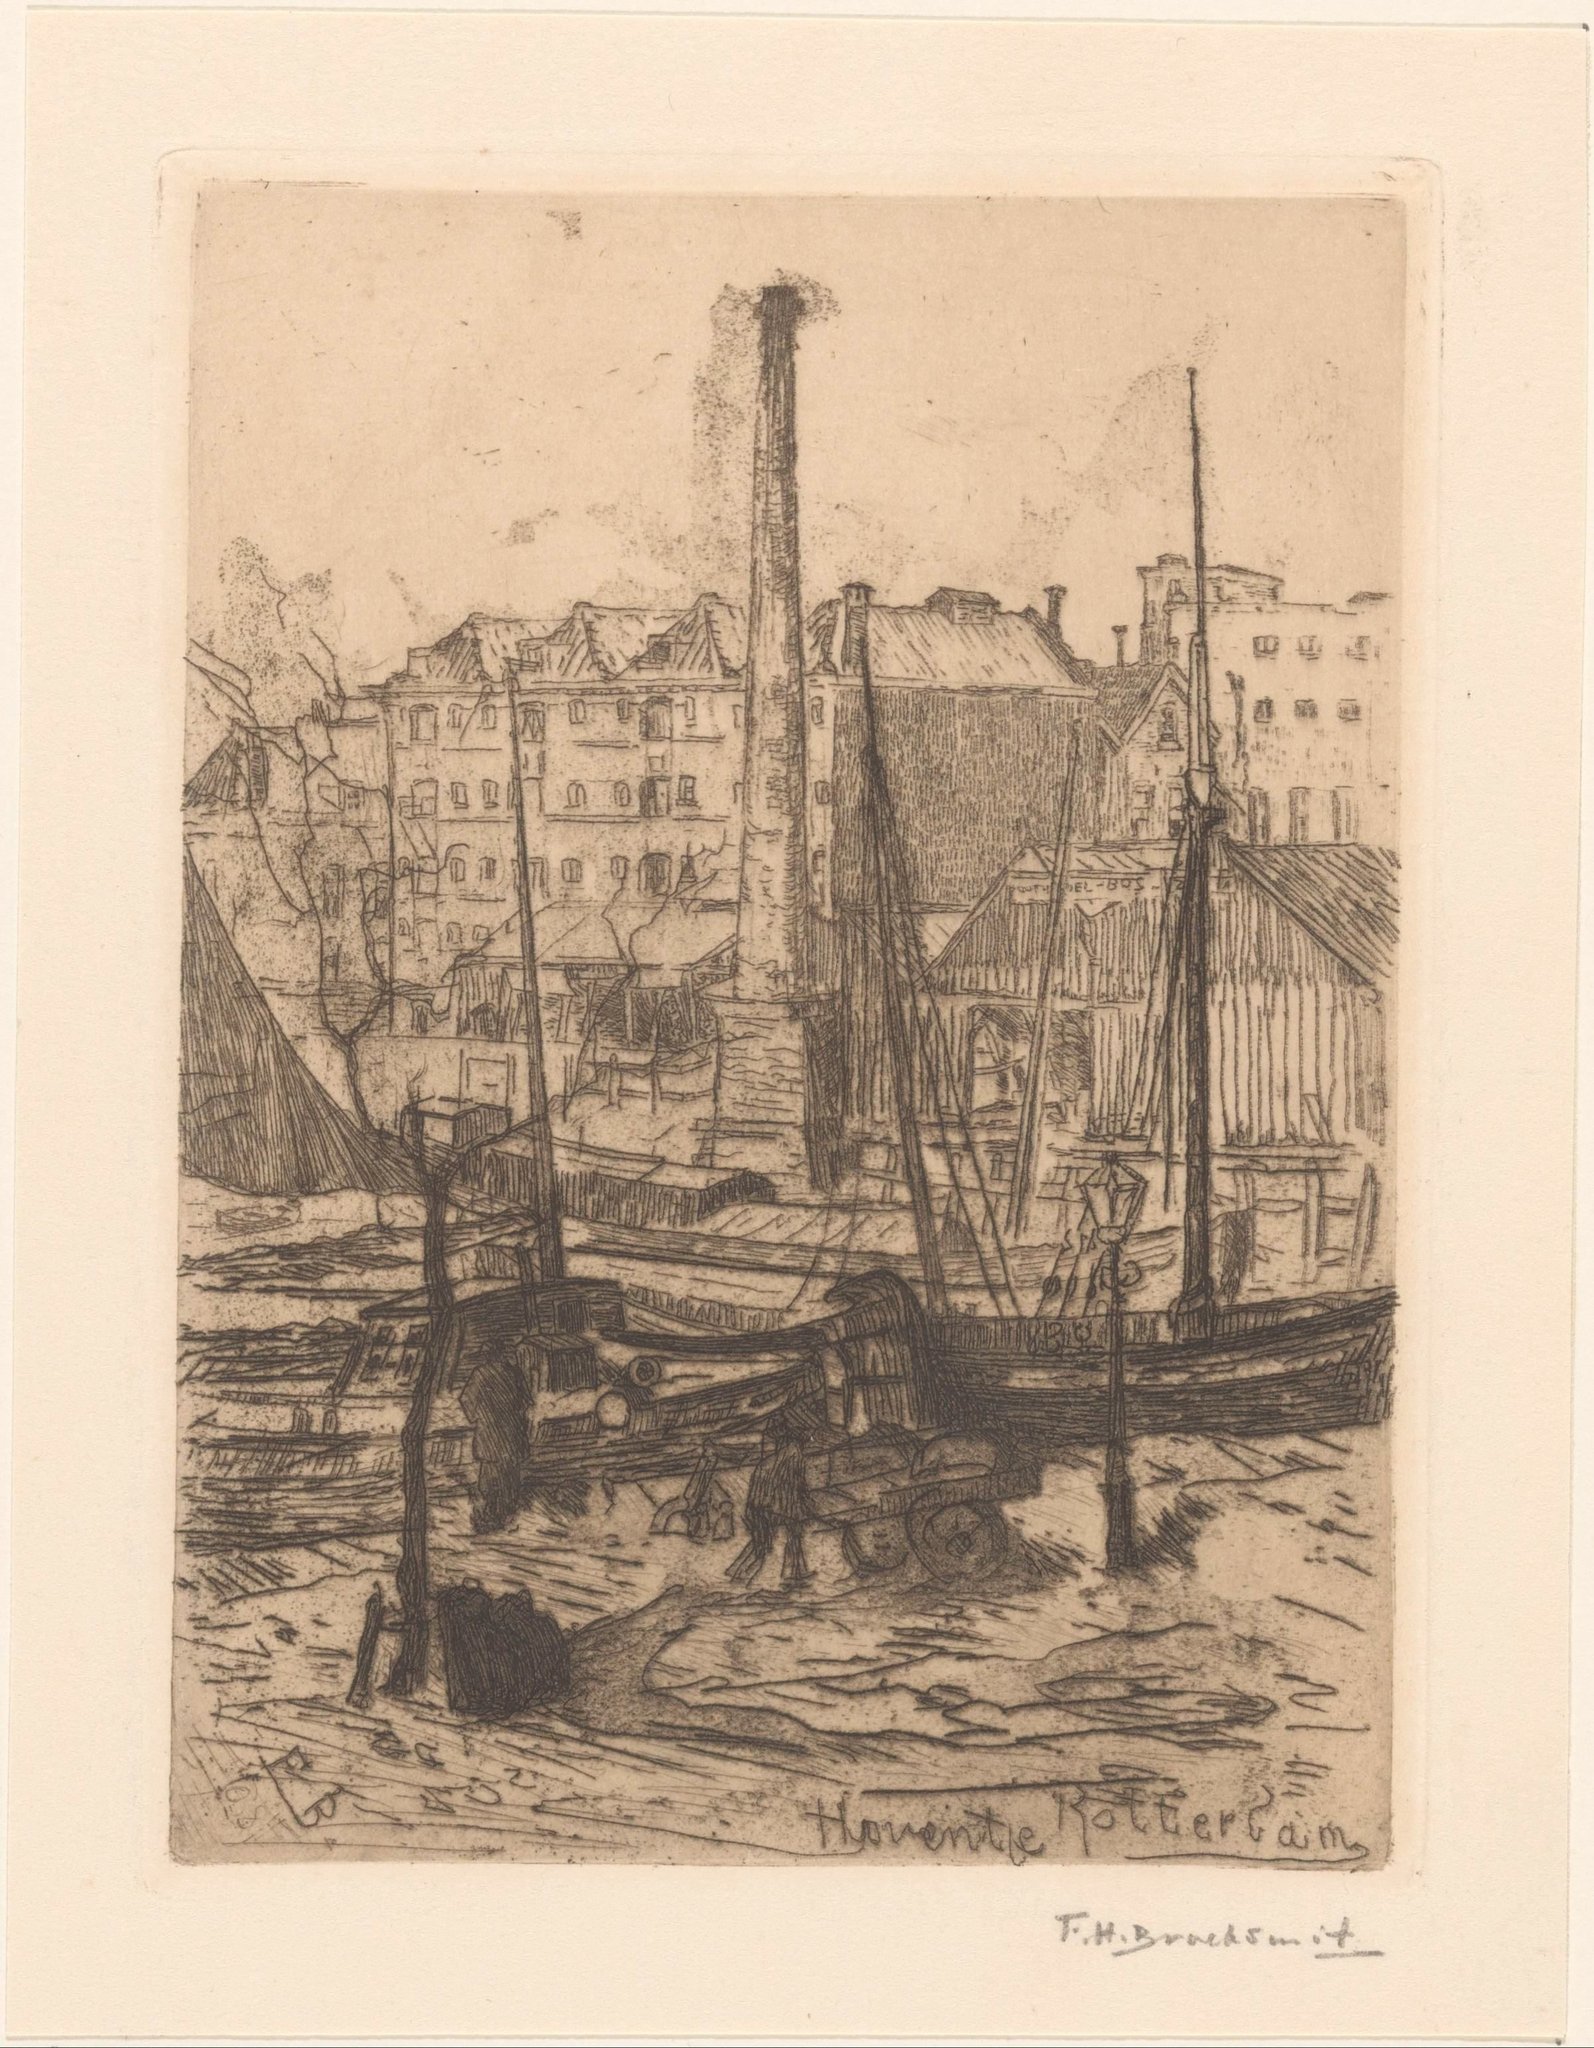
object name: print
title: Haventje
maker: frederika henriëtte broeksmit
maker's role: draughtsman, print maker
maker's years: 1875-1945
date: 1885-1931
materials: paper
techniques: etching, intaglio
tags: harbour, city-view, and landscape with man-made constructions, rotterdam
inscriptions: collector's mark: Lugt 2228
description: Een haven in Rotterdam. Op de kade een zuil of schoorsteen. Aan de kade een huizenrij.